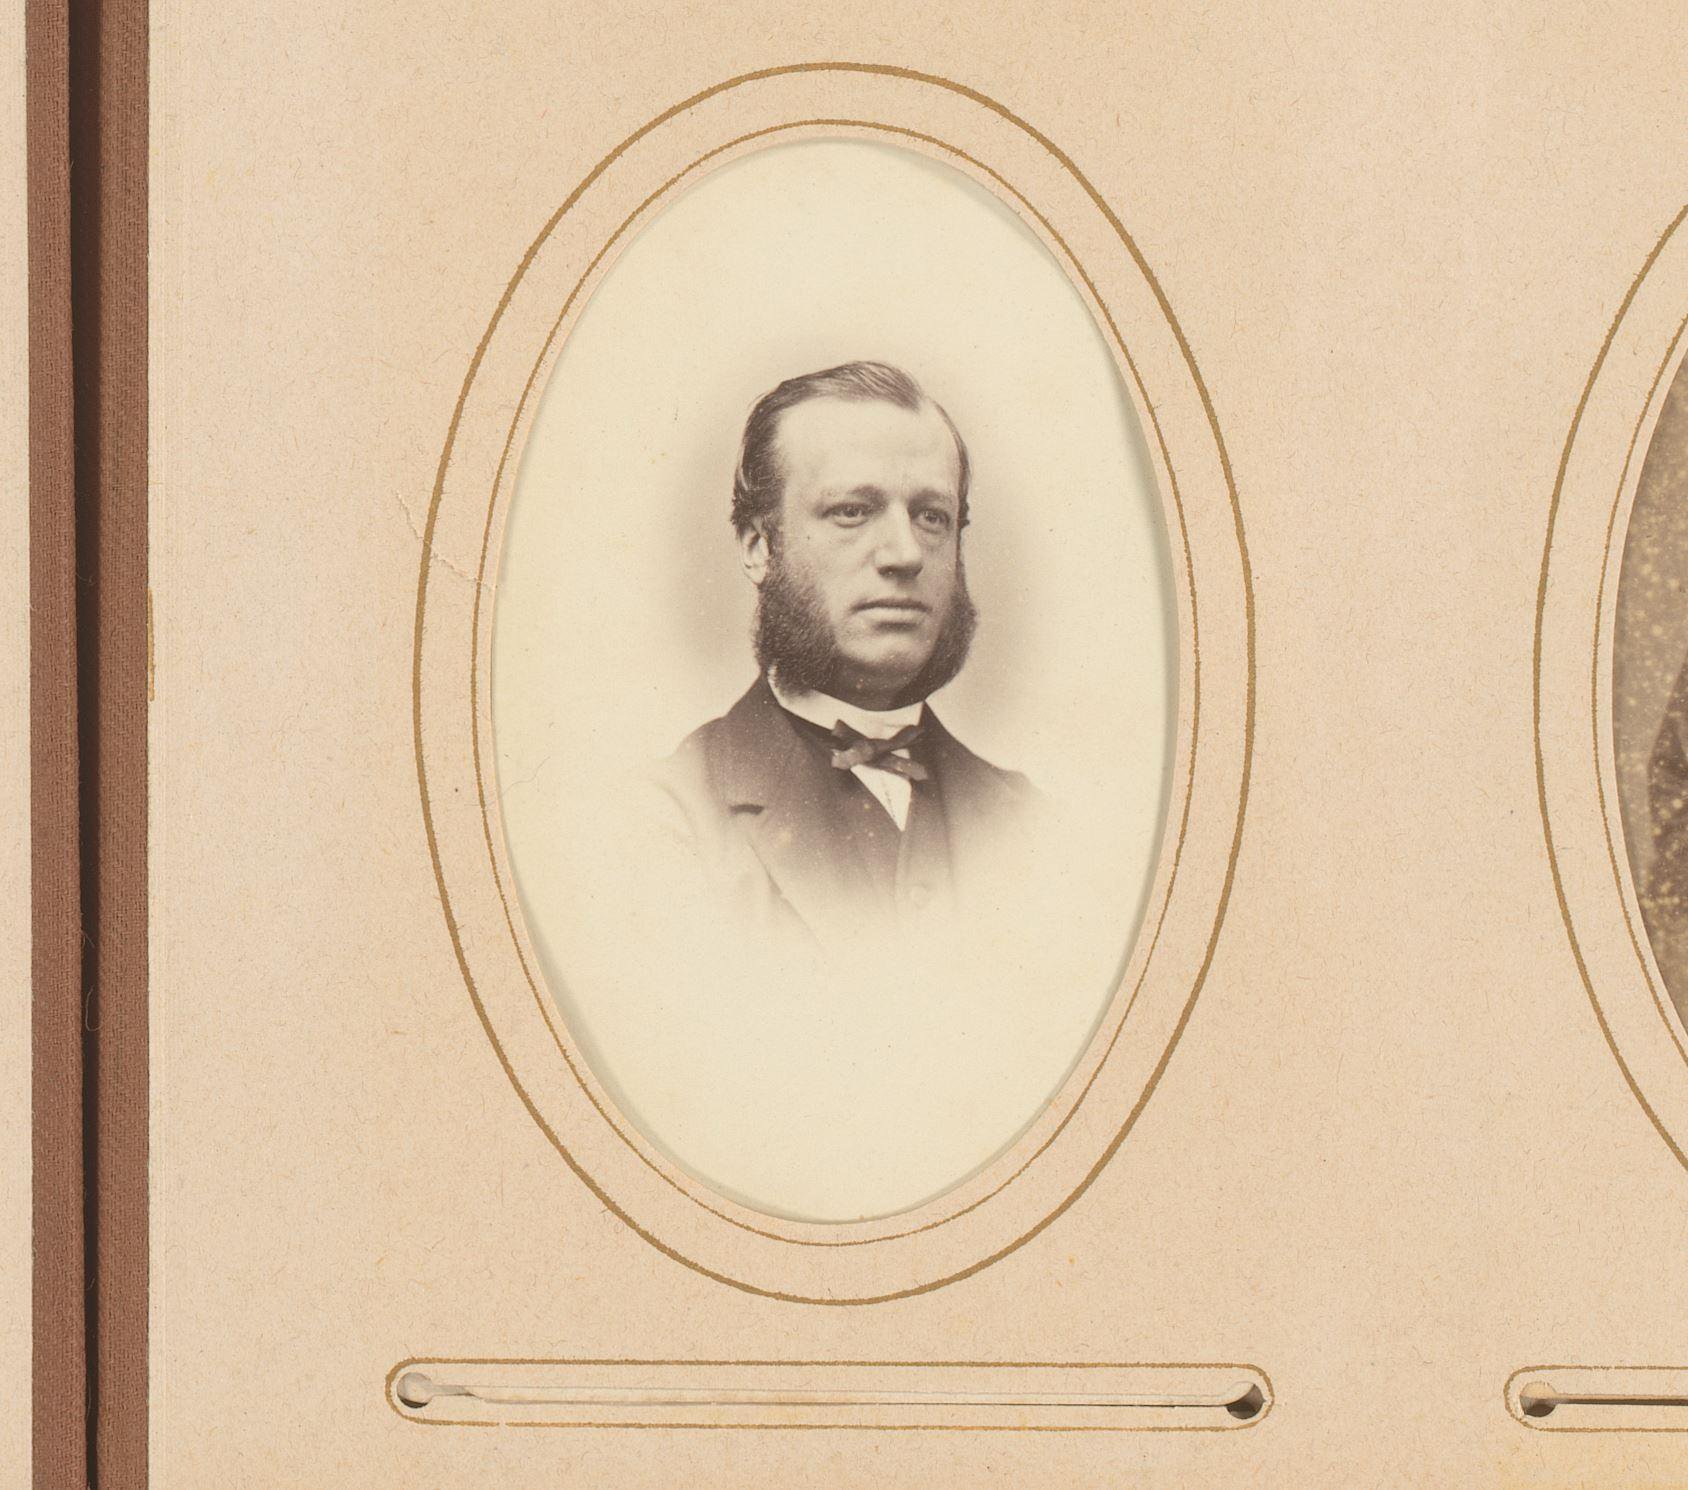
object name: photograph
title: Portret van een man met baard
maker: hendrik ede bontjes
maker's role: fotograaf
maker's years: 1832-1896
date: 1868-1871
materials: cardboard, photographic support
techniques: albumen print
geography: amsterdam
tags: historical persons, beard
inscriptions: inscription: ‘Photographisches Atelier van H.E. Bontjes/ Binnen-Amstel/ Tuscchen de Amstelstraat/ en Heerengracht/ P44/ Hooimarkt’